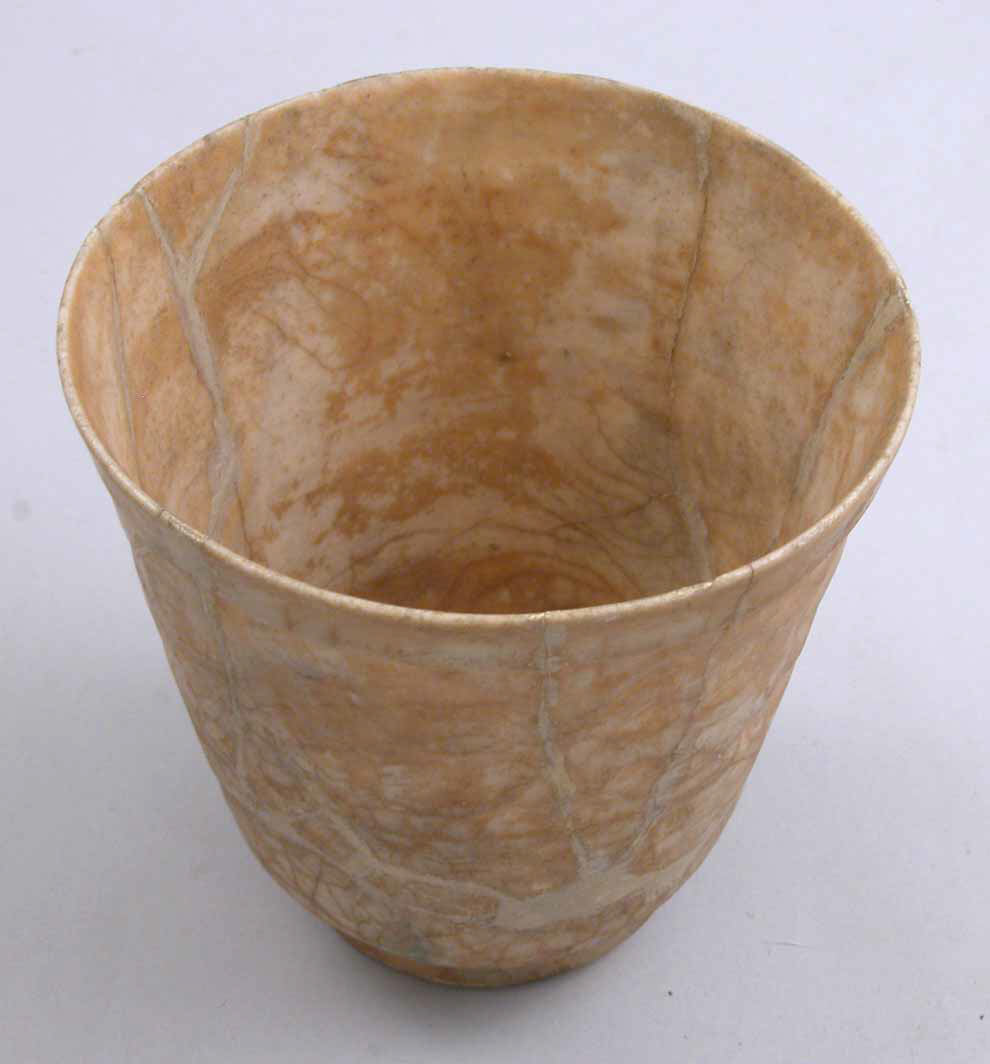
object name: cup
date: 1101-1300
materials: earthenware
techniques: glazing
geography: iran